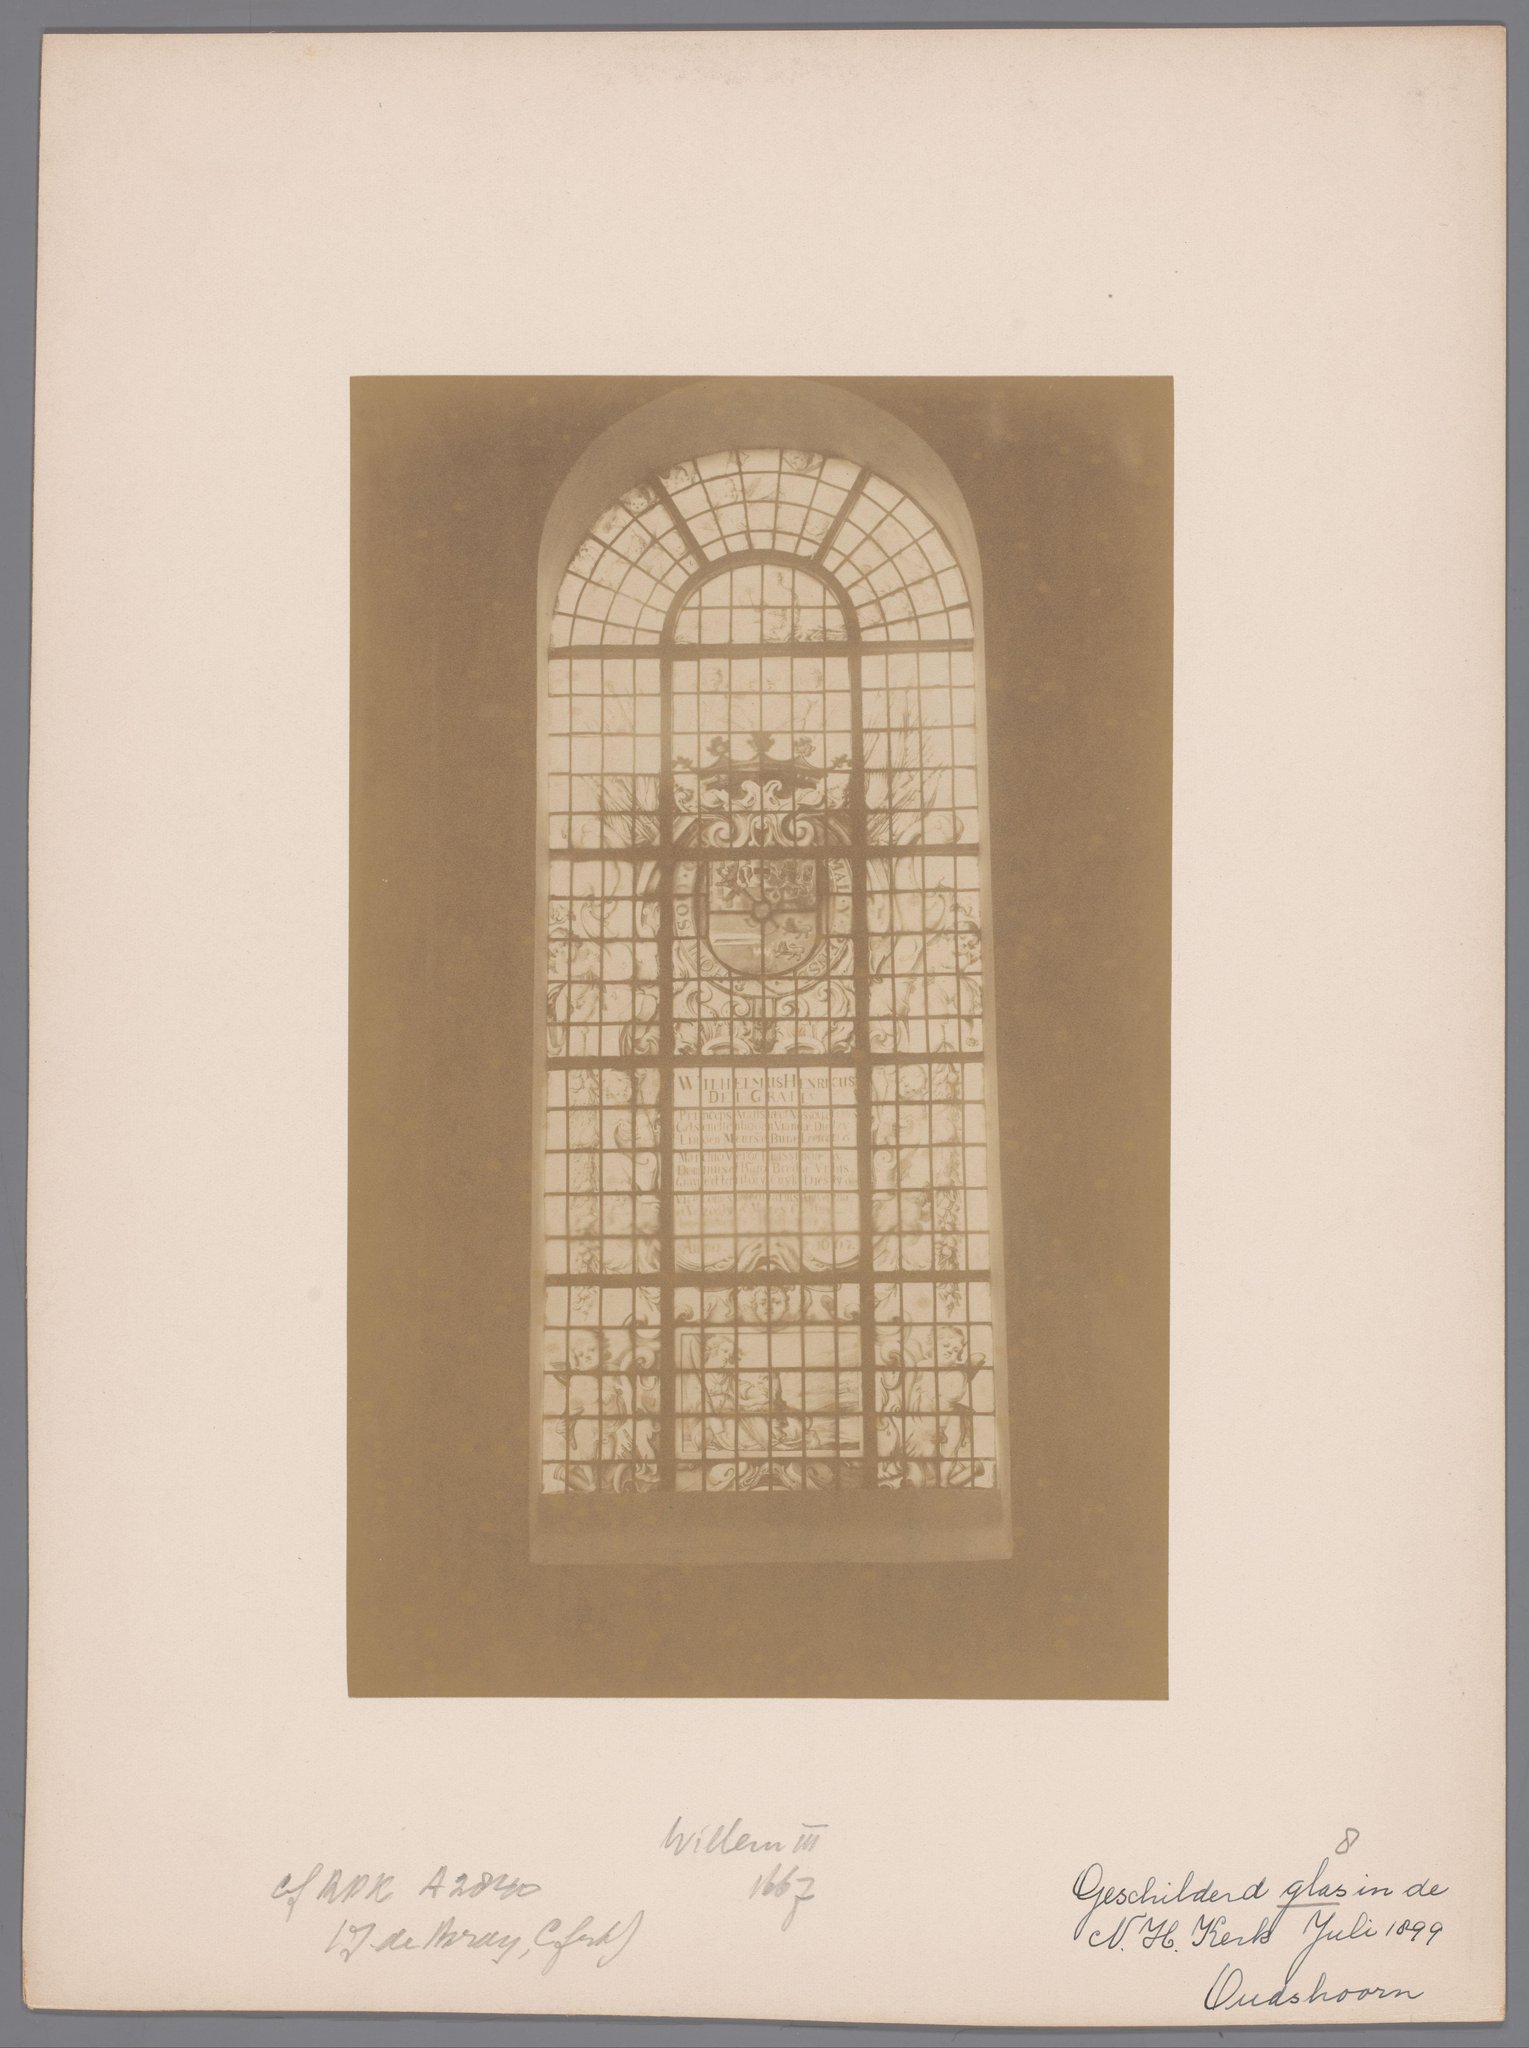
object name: photograph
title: Geschilderd raam in de Oudshoornse Kerk te Oudshoorn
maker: anoniem (monumentenzorg)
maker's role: fotograaf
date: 1899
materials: cardboard, photographic support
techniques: albumen print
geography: oudshoorn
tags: church-window, e.g. rose-window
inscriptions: annotation: ‘Geschilderd glas 8 in de N.H. Kerk Juli 1899/ Oudshoorn’, annotation: ‘Geschilderd glas in de Ned Herv kerk te Oudshoorn/ Juli 1899’, annotation: ‘[...] RPK A2840 [...]/ Willem III’